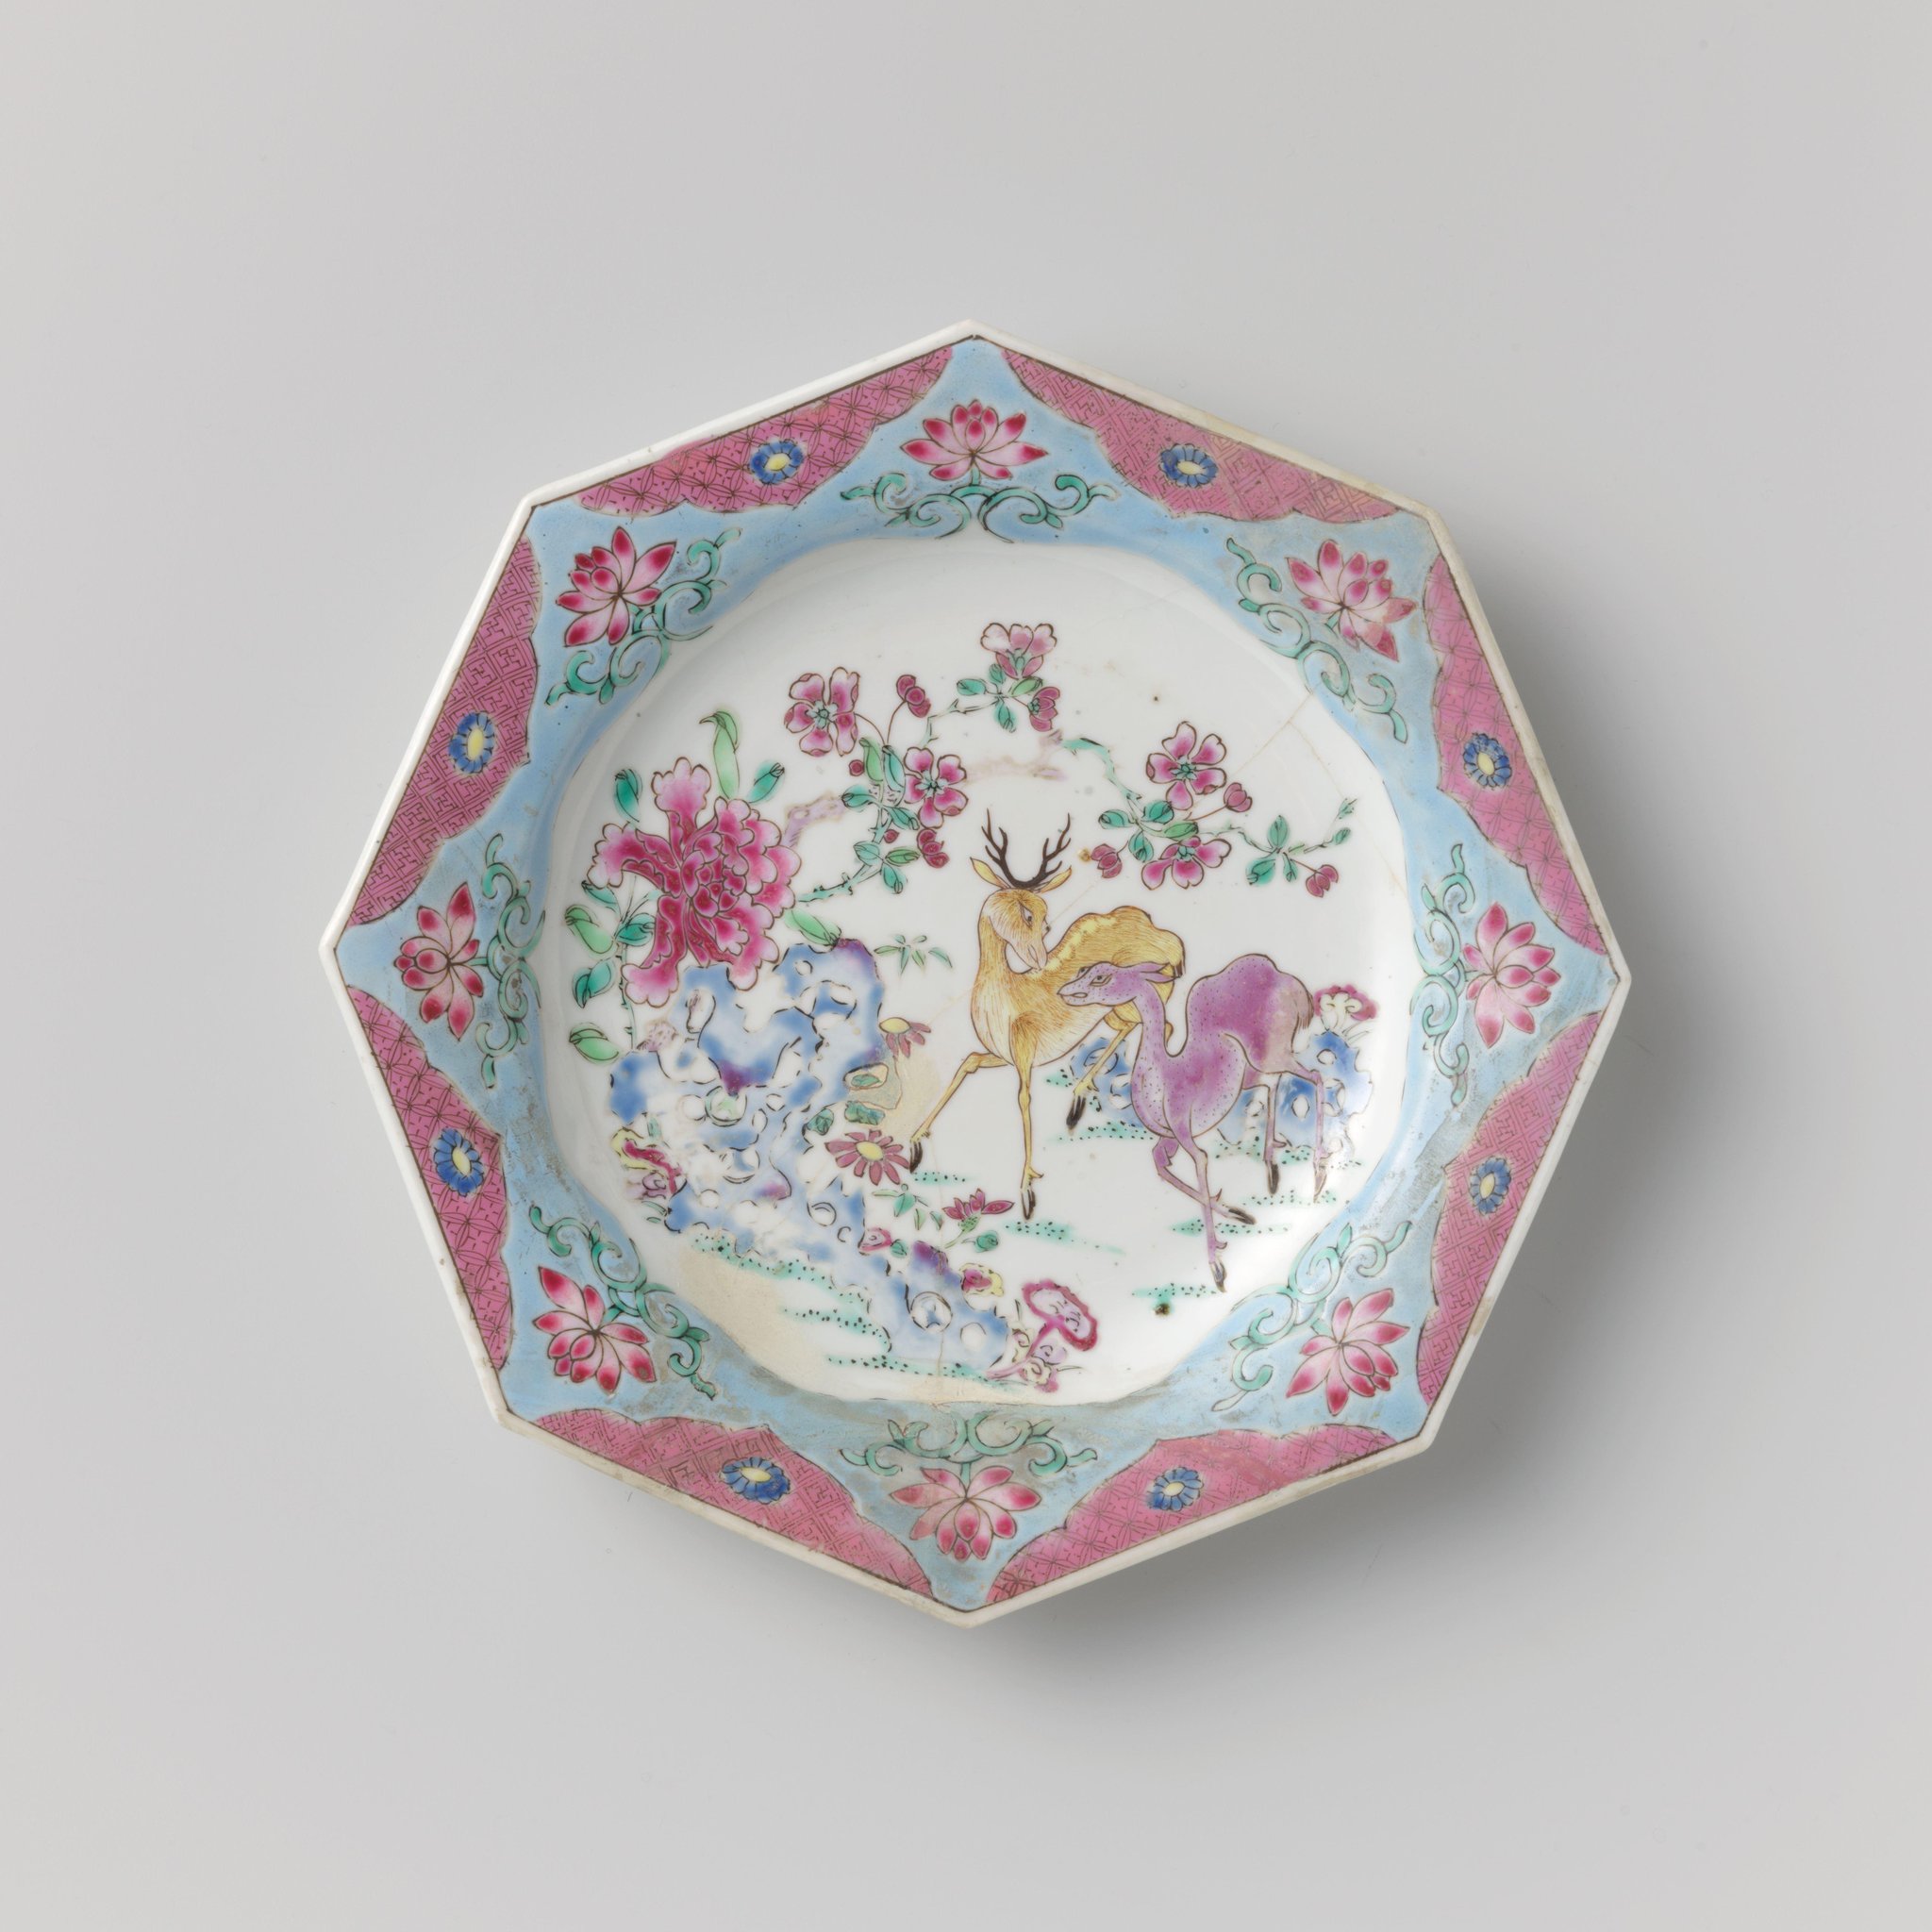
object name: plate dish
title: Octagonal plate with two deer near rocks and flowering plants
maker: Anonymous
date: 1725-1749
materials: glaze, gold, paint, porcelain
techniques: firing, forming, gilding, turning, vitrification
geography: china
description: Achthoekig bord van porselein, beschilderd op het glazuur in blauw, rood, roze, groen, geel, paars en zwart. Op het plat twee herten bij rotsen en bloeiende planten en paddenstoelen (lingzhi); de rand met acht halve geschulpte cartouches met een bloem op servetwerk, daartussen acht gestileerde lotusranken tegen een blauwe grond. Bord is gebroken geweest. Famille rose.